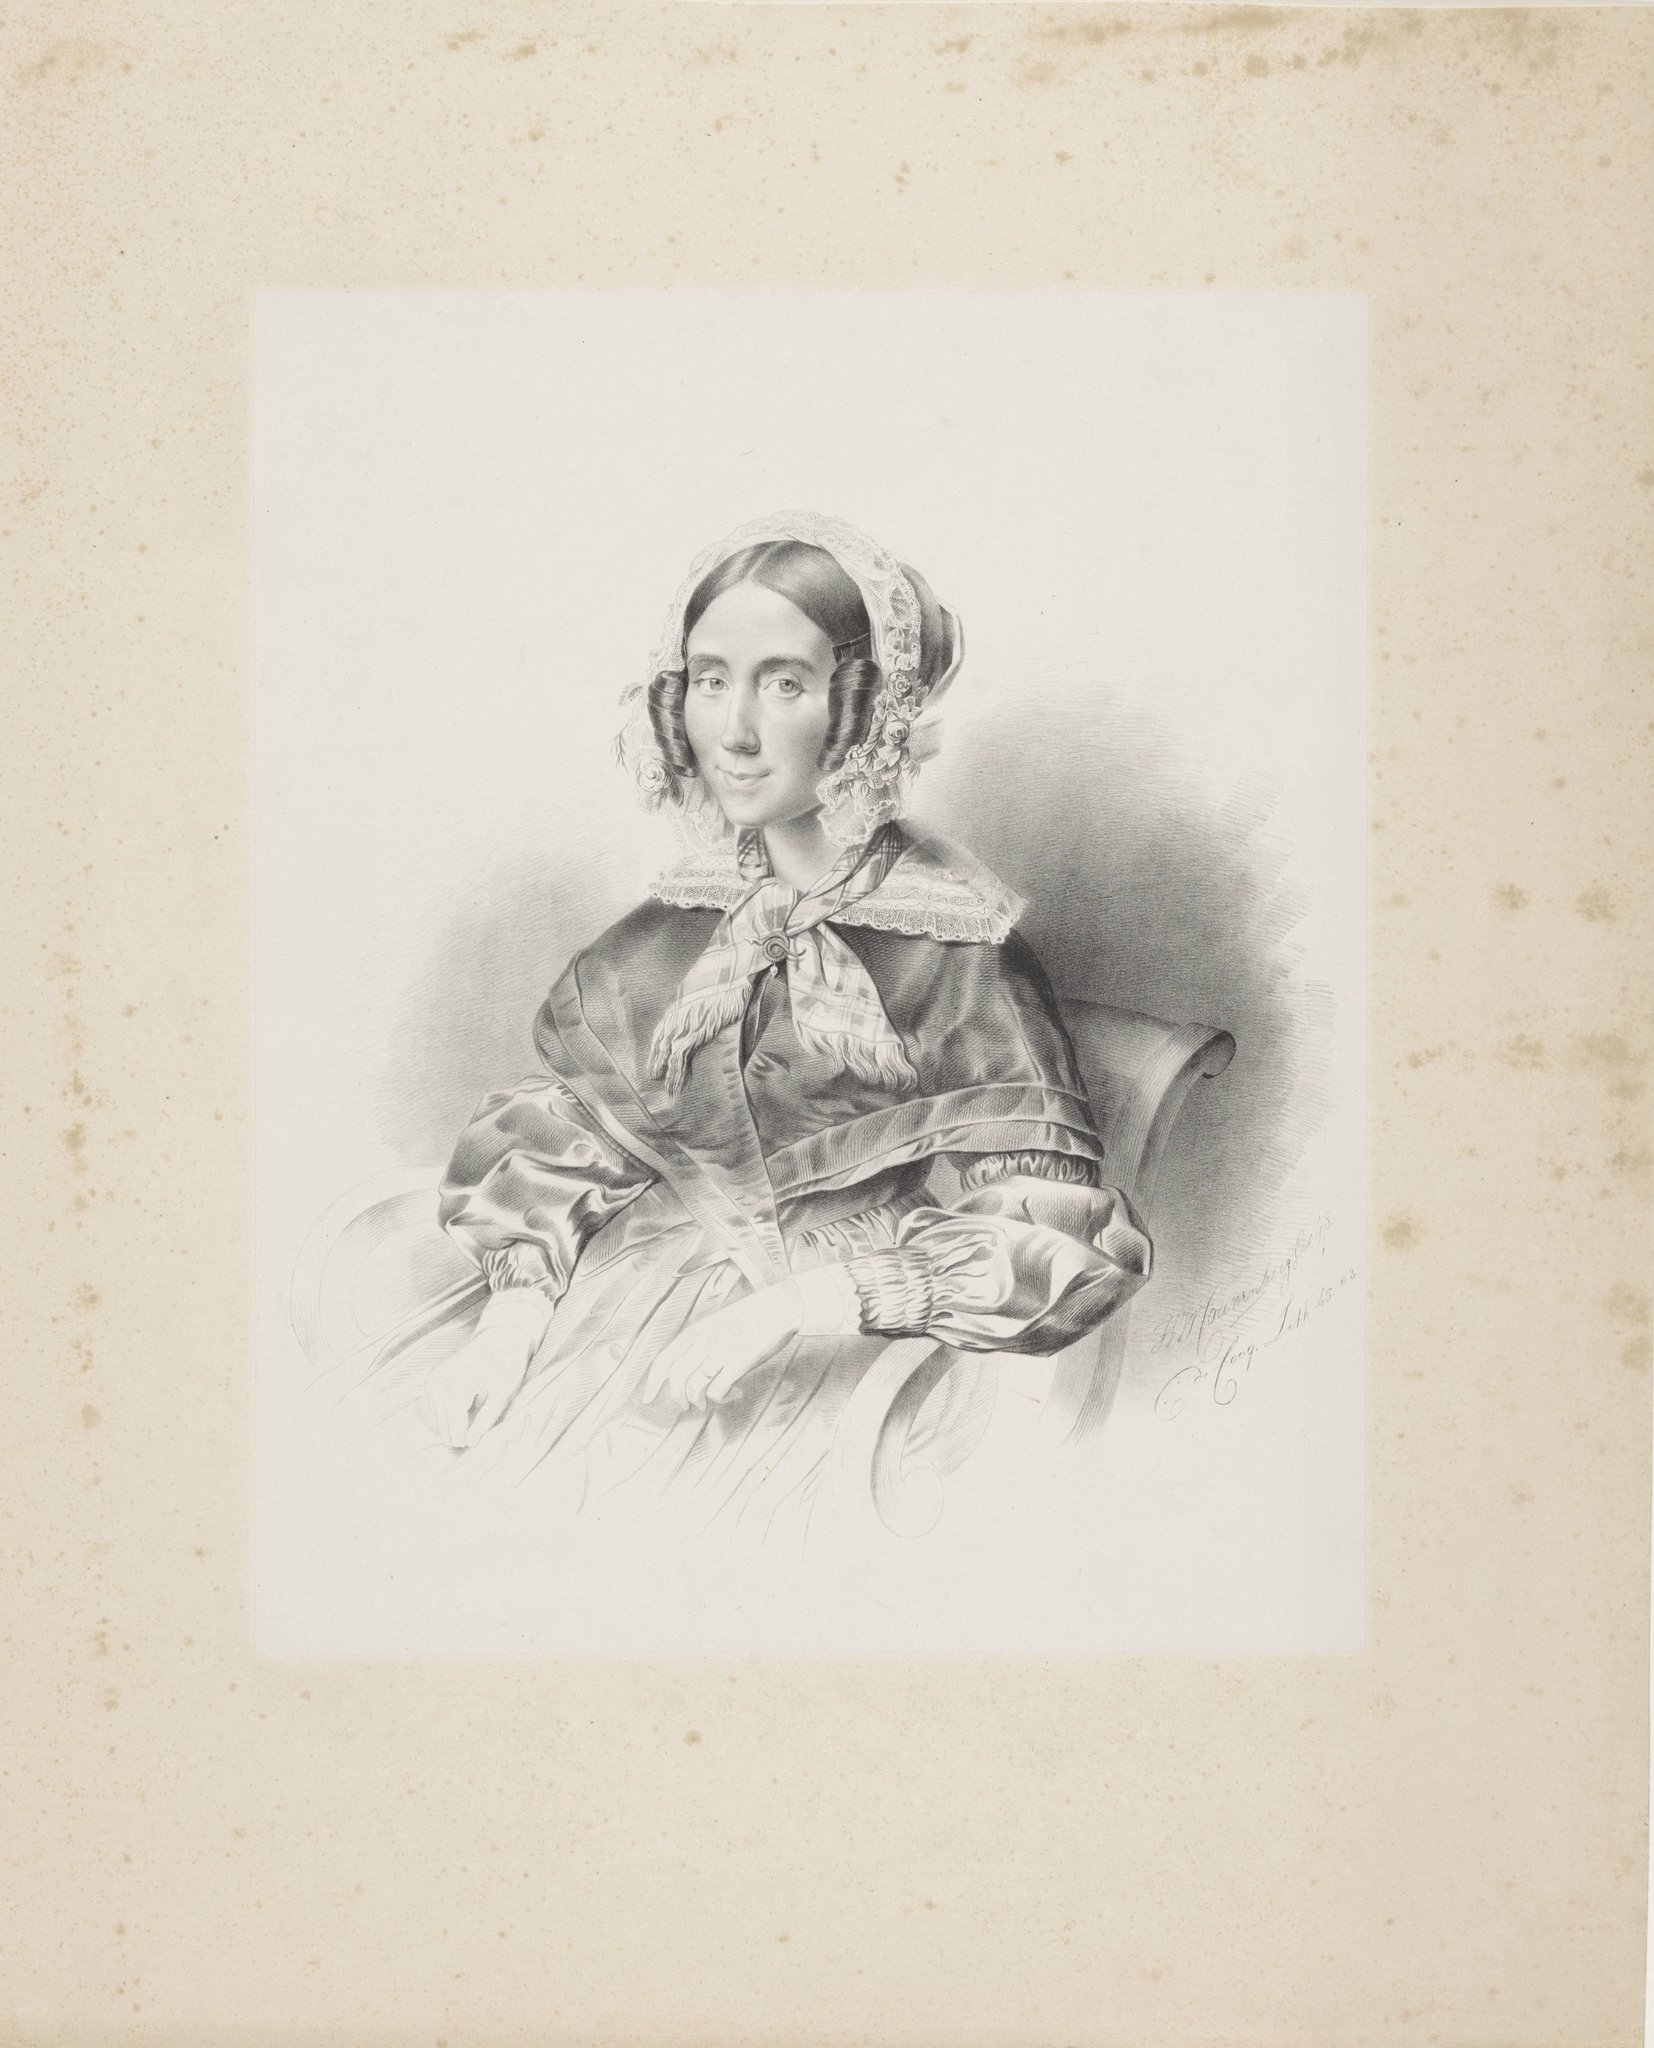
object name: print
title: Portret van een onbekende vrouw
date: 1845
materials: paper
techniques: lithograph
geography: netherlands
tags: historical persons - bb - woman (+ (full) bust portrait), snakes (+ ornamental variants of animals), head-gear: cap, pin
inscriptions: collector's mark: Lugt 2228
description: De geportretteerde zit op een stoel en draagt een geruite sjaal over een kanten kraag. Bij de knoop zit een speld in de vorm van een slang. Op haar hoofd draagt zij een kapje versierd met bloemen.